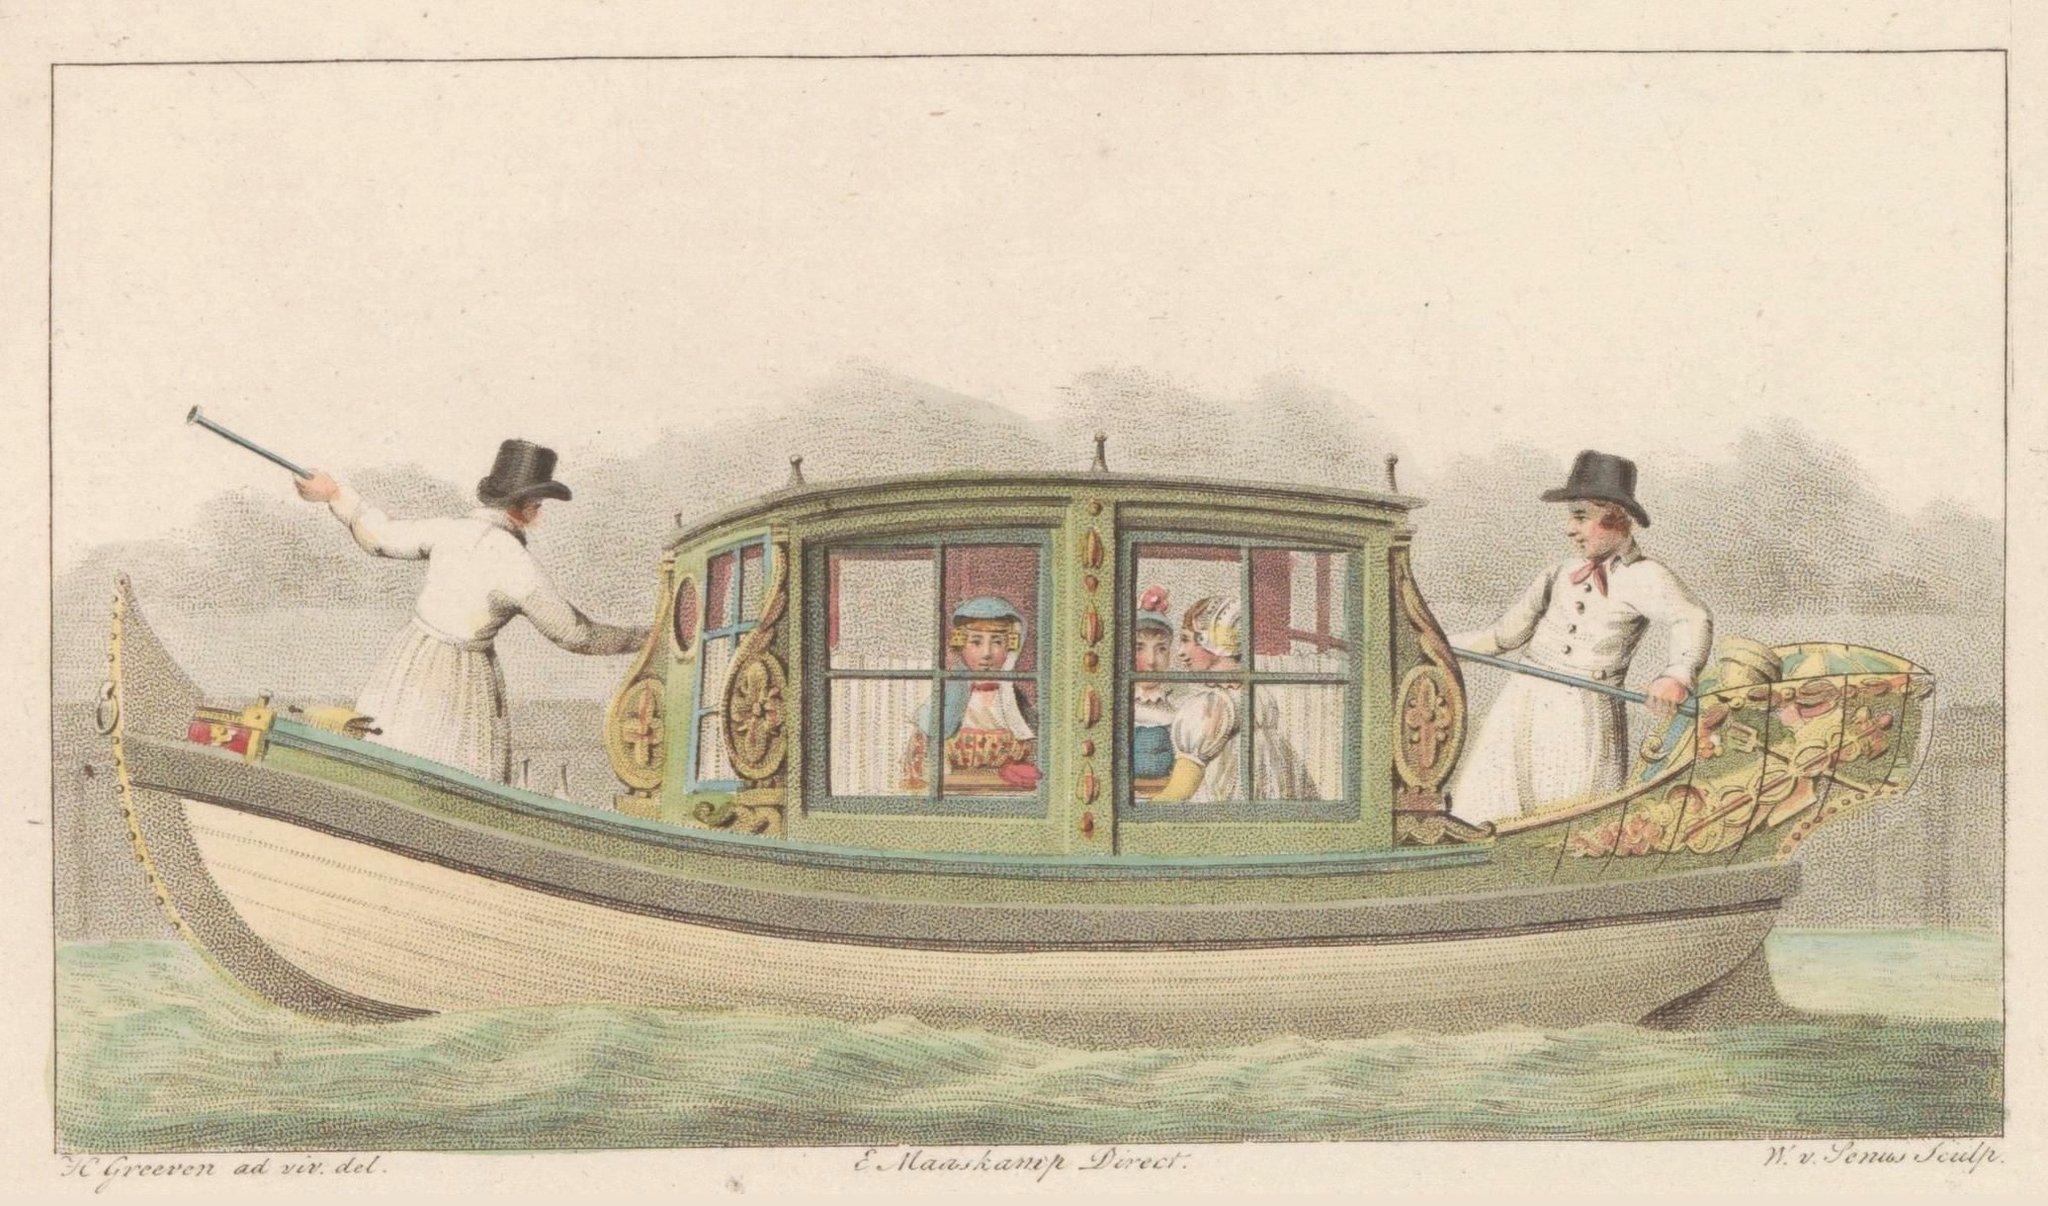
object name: print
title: Zaans tentjacht, 1816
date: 1816-1817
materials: paper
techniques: etching, hand coloring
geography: amsterdam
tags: boat propelled by man or animal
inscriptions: inscription: ‘Une barque de Compagnie nommée Tentjagje à Zaandam’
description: Verschillende personen laten zich in een tentjacht over de Zaan vervoeren, 1816. Onderdeel van een plaatwerk uit ca. 1824-1825 met 74 (ongenummerde) platen van de belangrijkste topografische gezichten en verschillende zeden en gewoonten in het Verenigd Koninkrijk der Nederlanden.